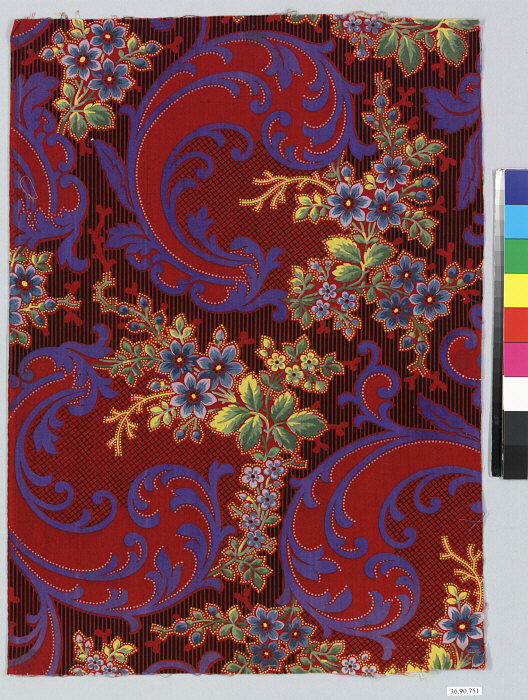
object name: piece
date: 1867-1900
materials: cotton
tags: flowers,leaves